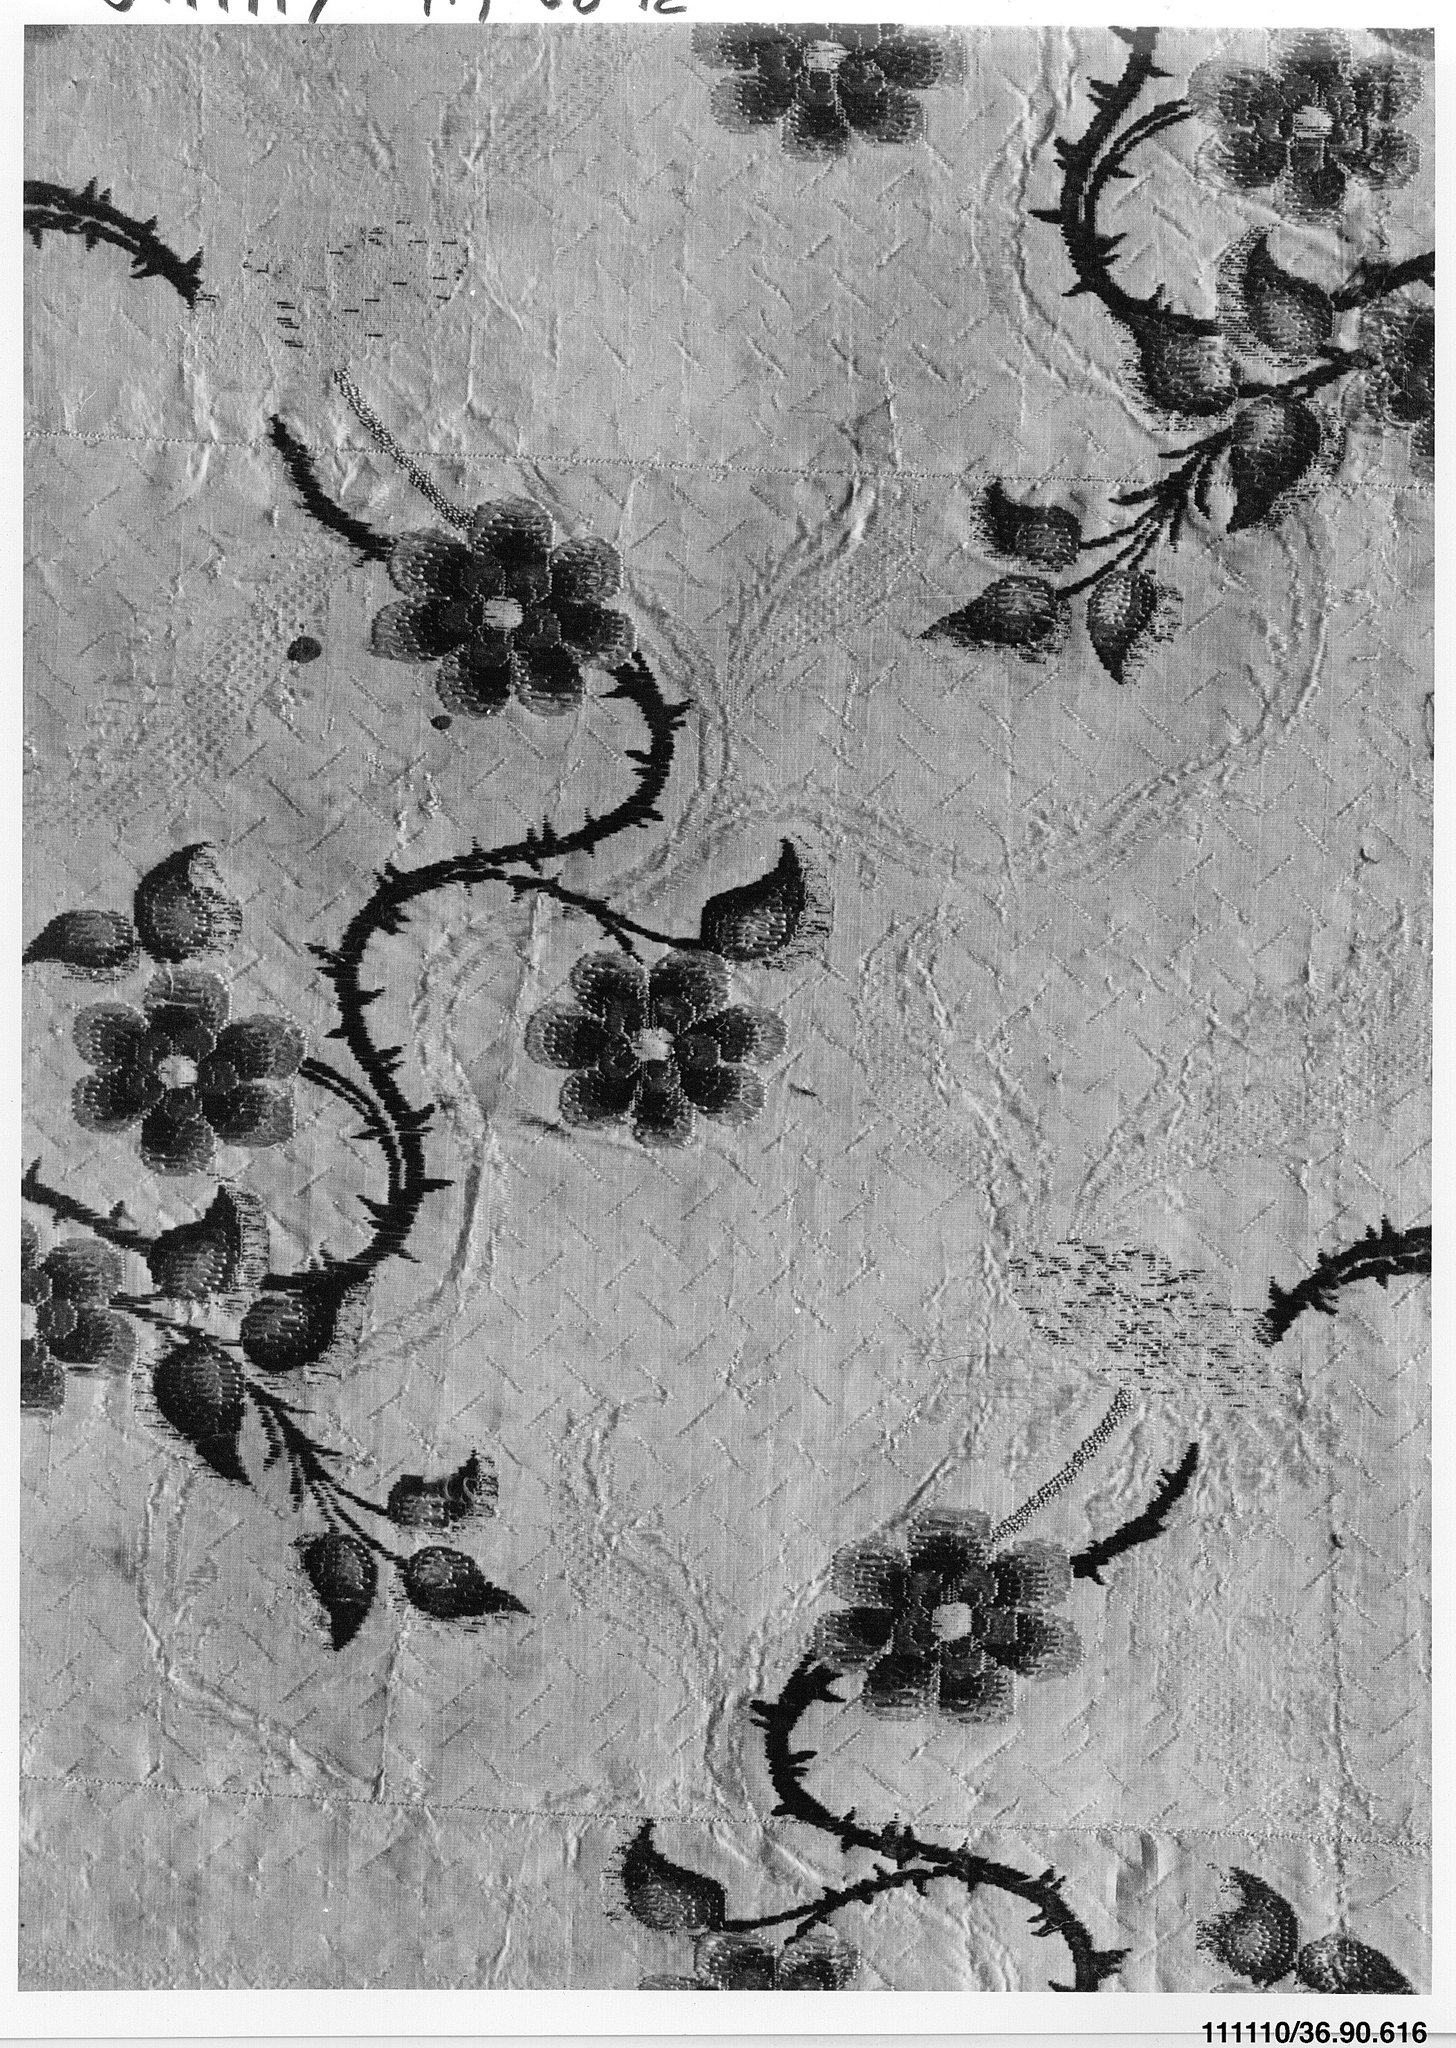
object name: piece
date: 1734-1766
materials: metal thread, silk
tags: flowers,leaves